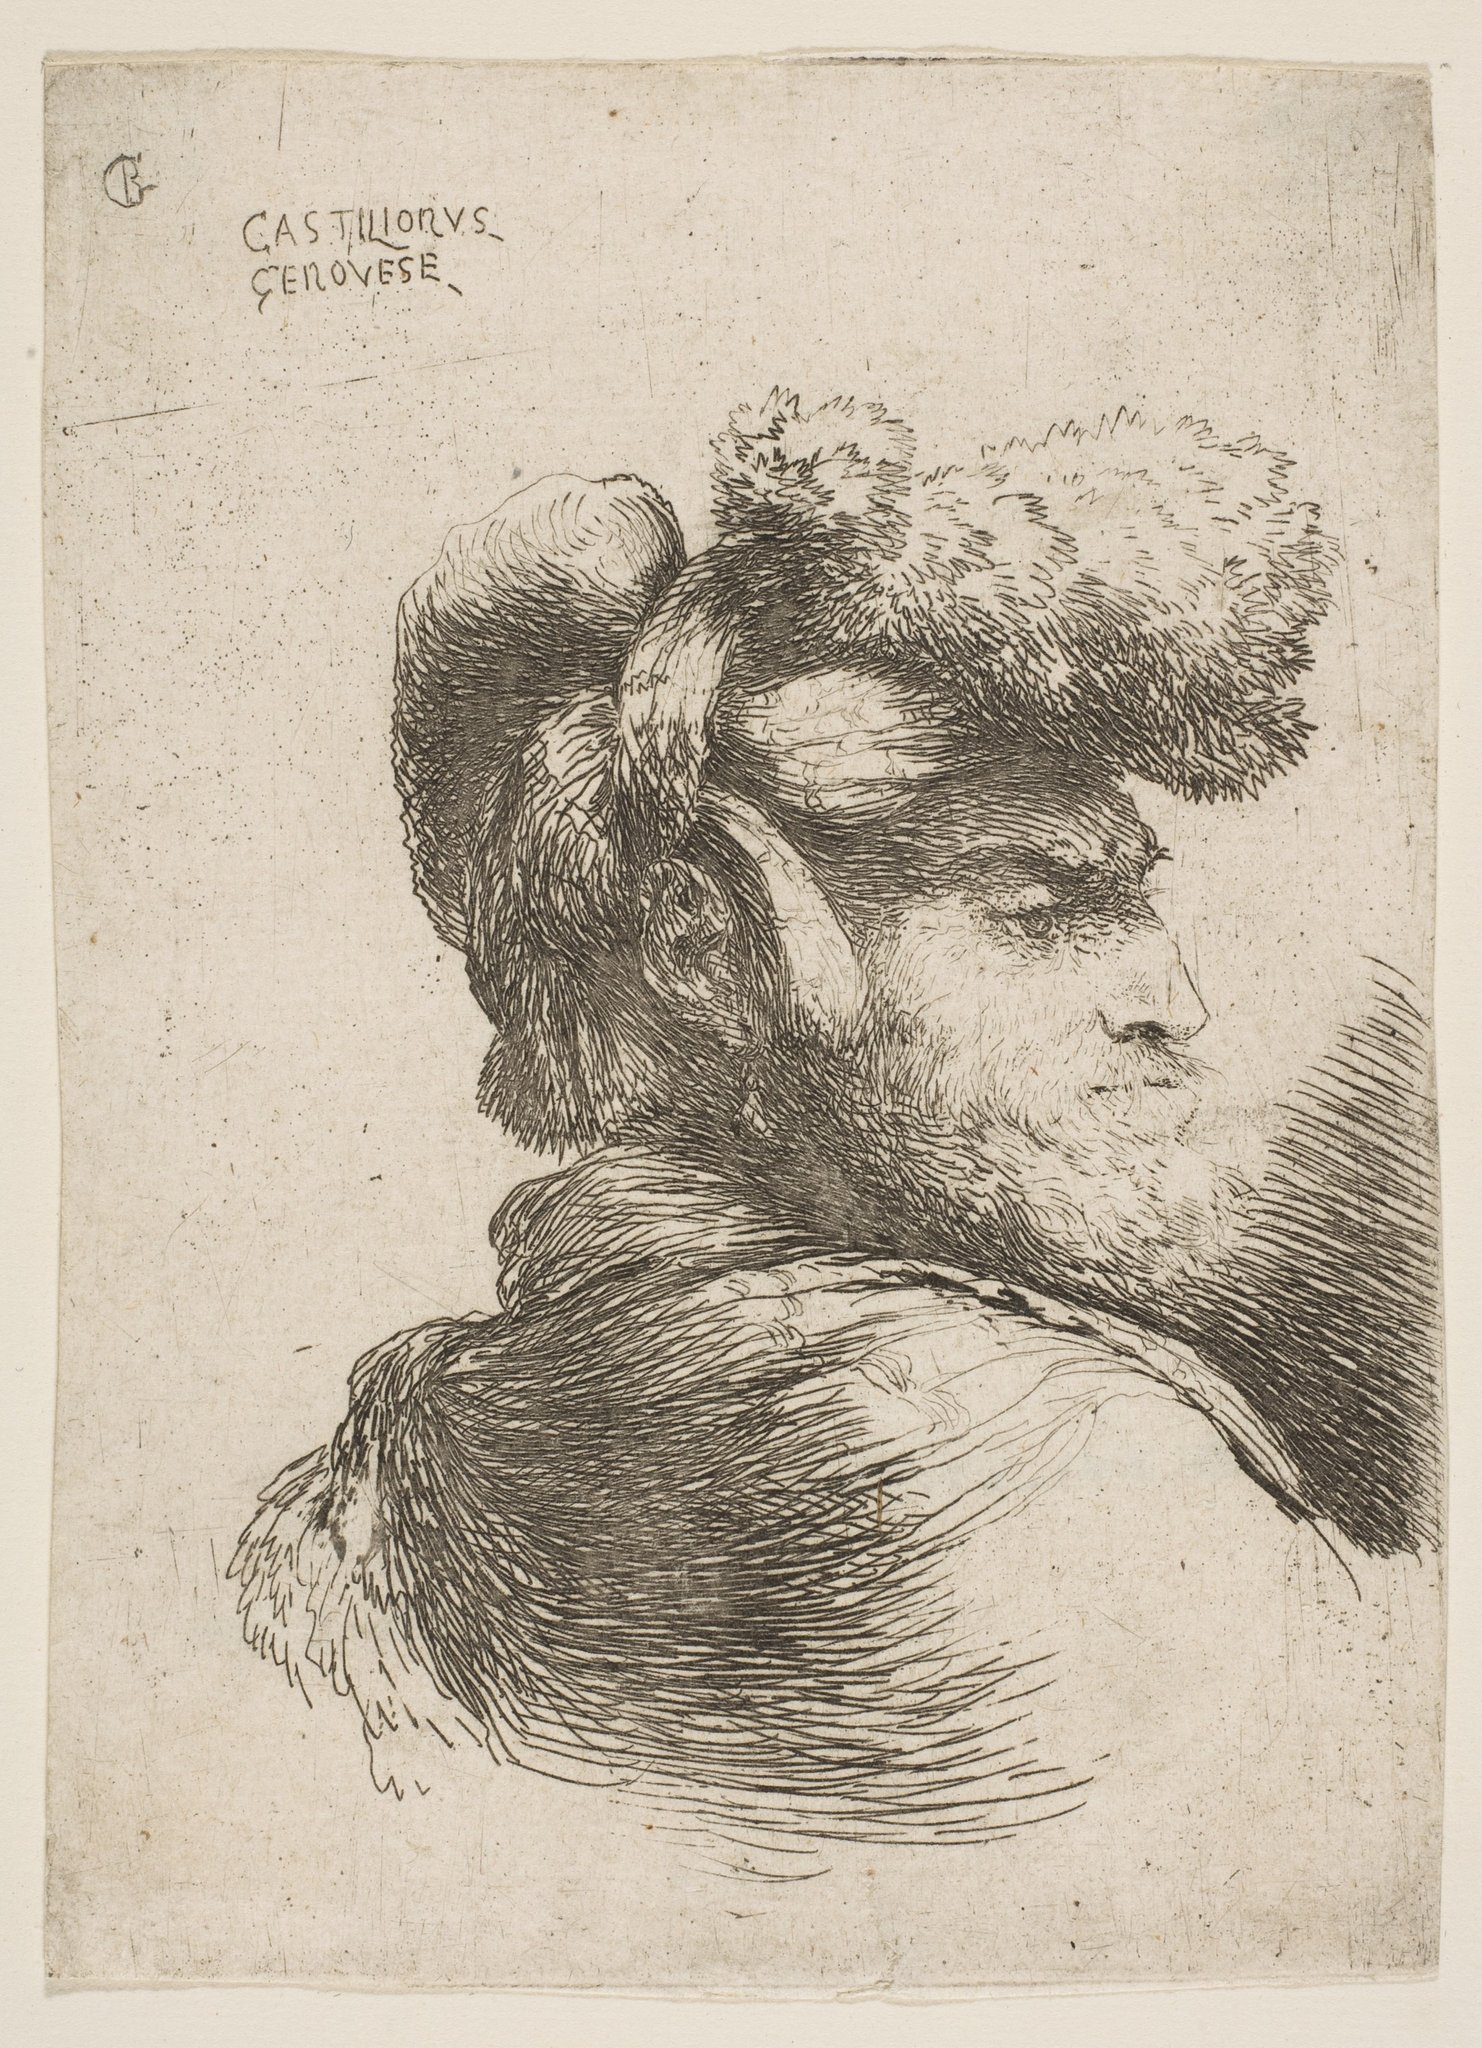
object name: print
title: Man in profile facing right, wearing a fur hat, from "Small Heads in Oriental Headdress"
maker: giovanni benedetto castiglione (il grechetto)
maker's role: artist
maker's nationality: italian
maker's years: 1609-1664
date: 1645-1650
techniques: etching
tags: hats,men